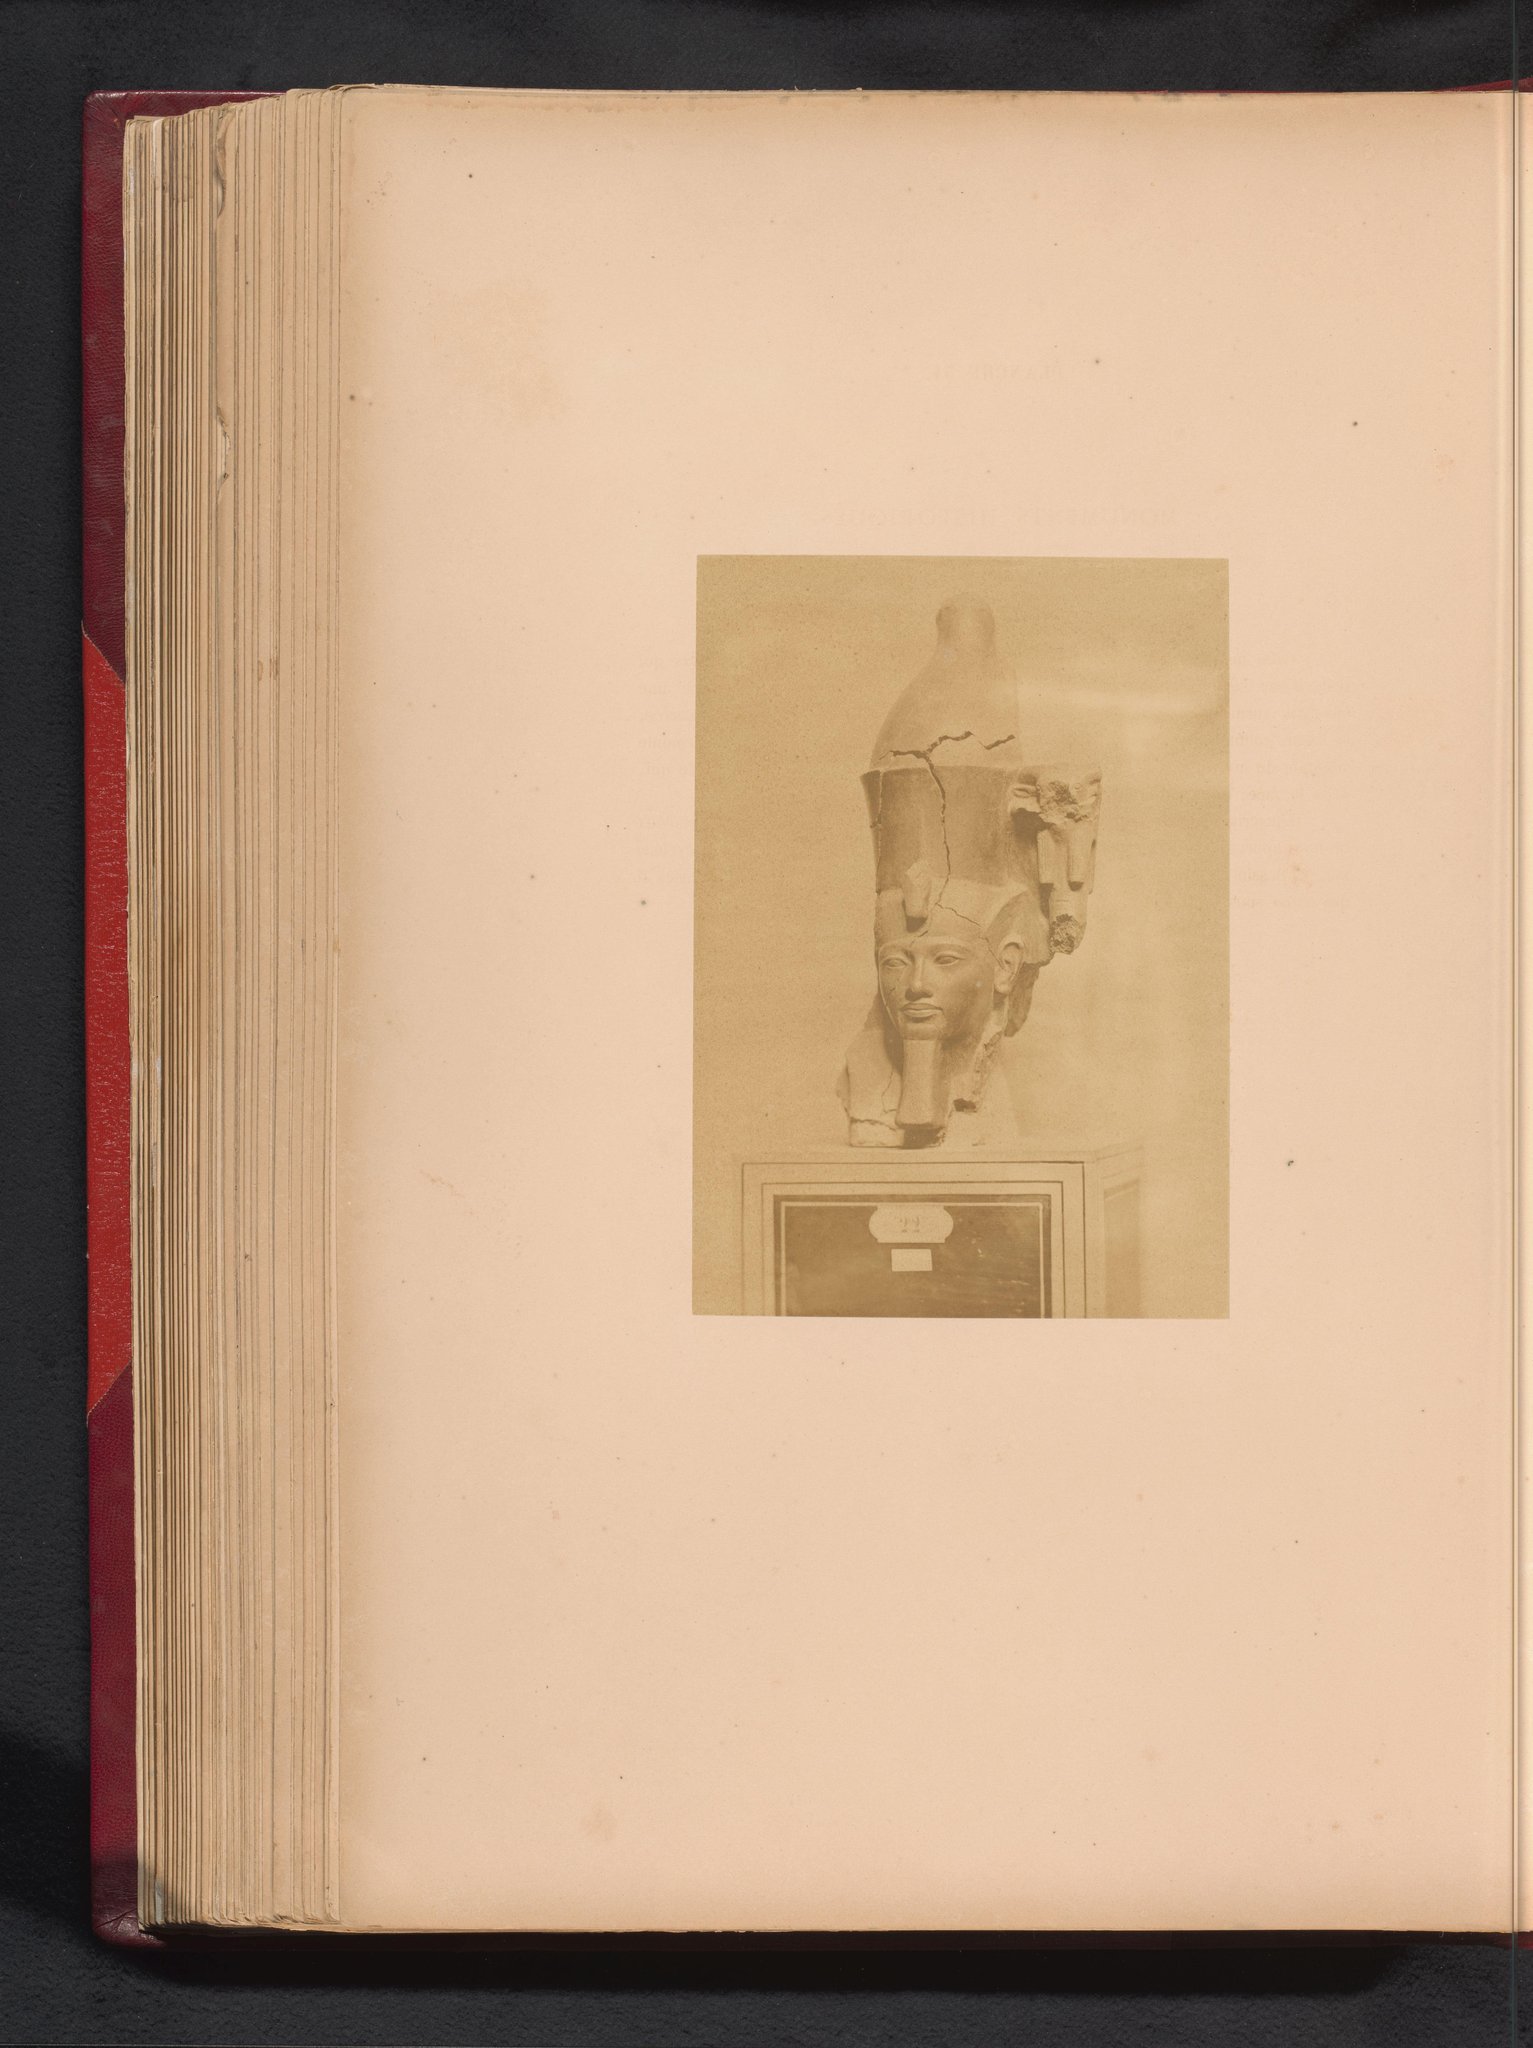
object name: page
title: Hoofd van een Egyptisch standbeeld in het Boulaq Museum in Caïro, Egypte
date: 1866-1871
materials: photographic support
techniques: albumen print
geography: cairo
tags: piece of sculpture, reproduction of a piece of sculpture (+ egyptian art), permanent exhibition, museum